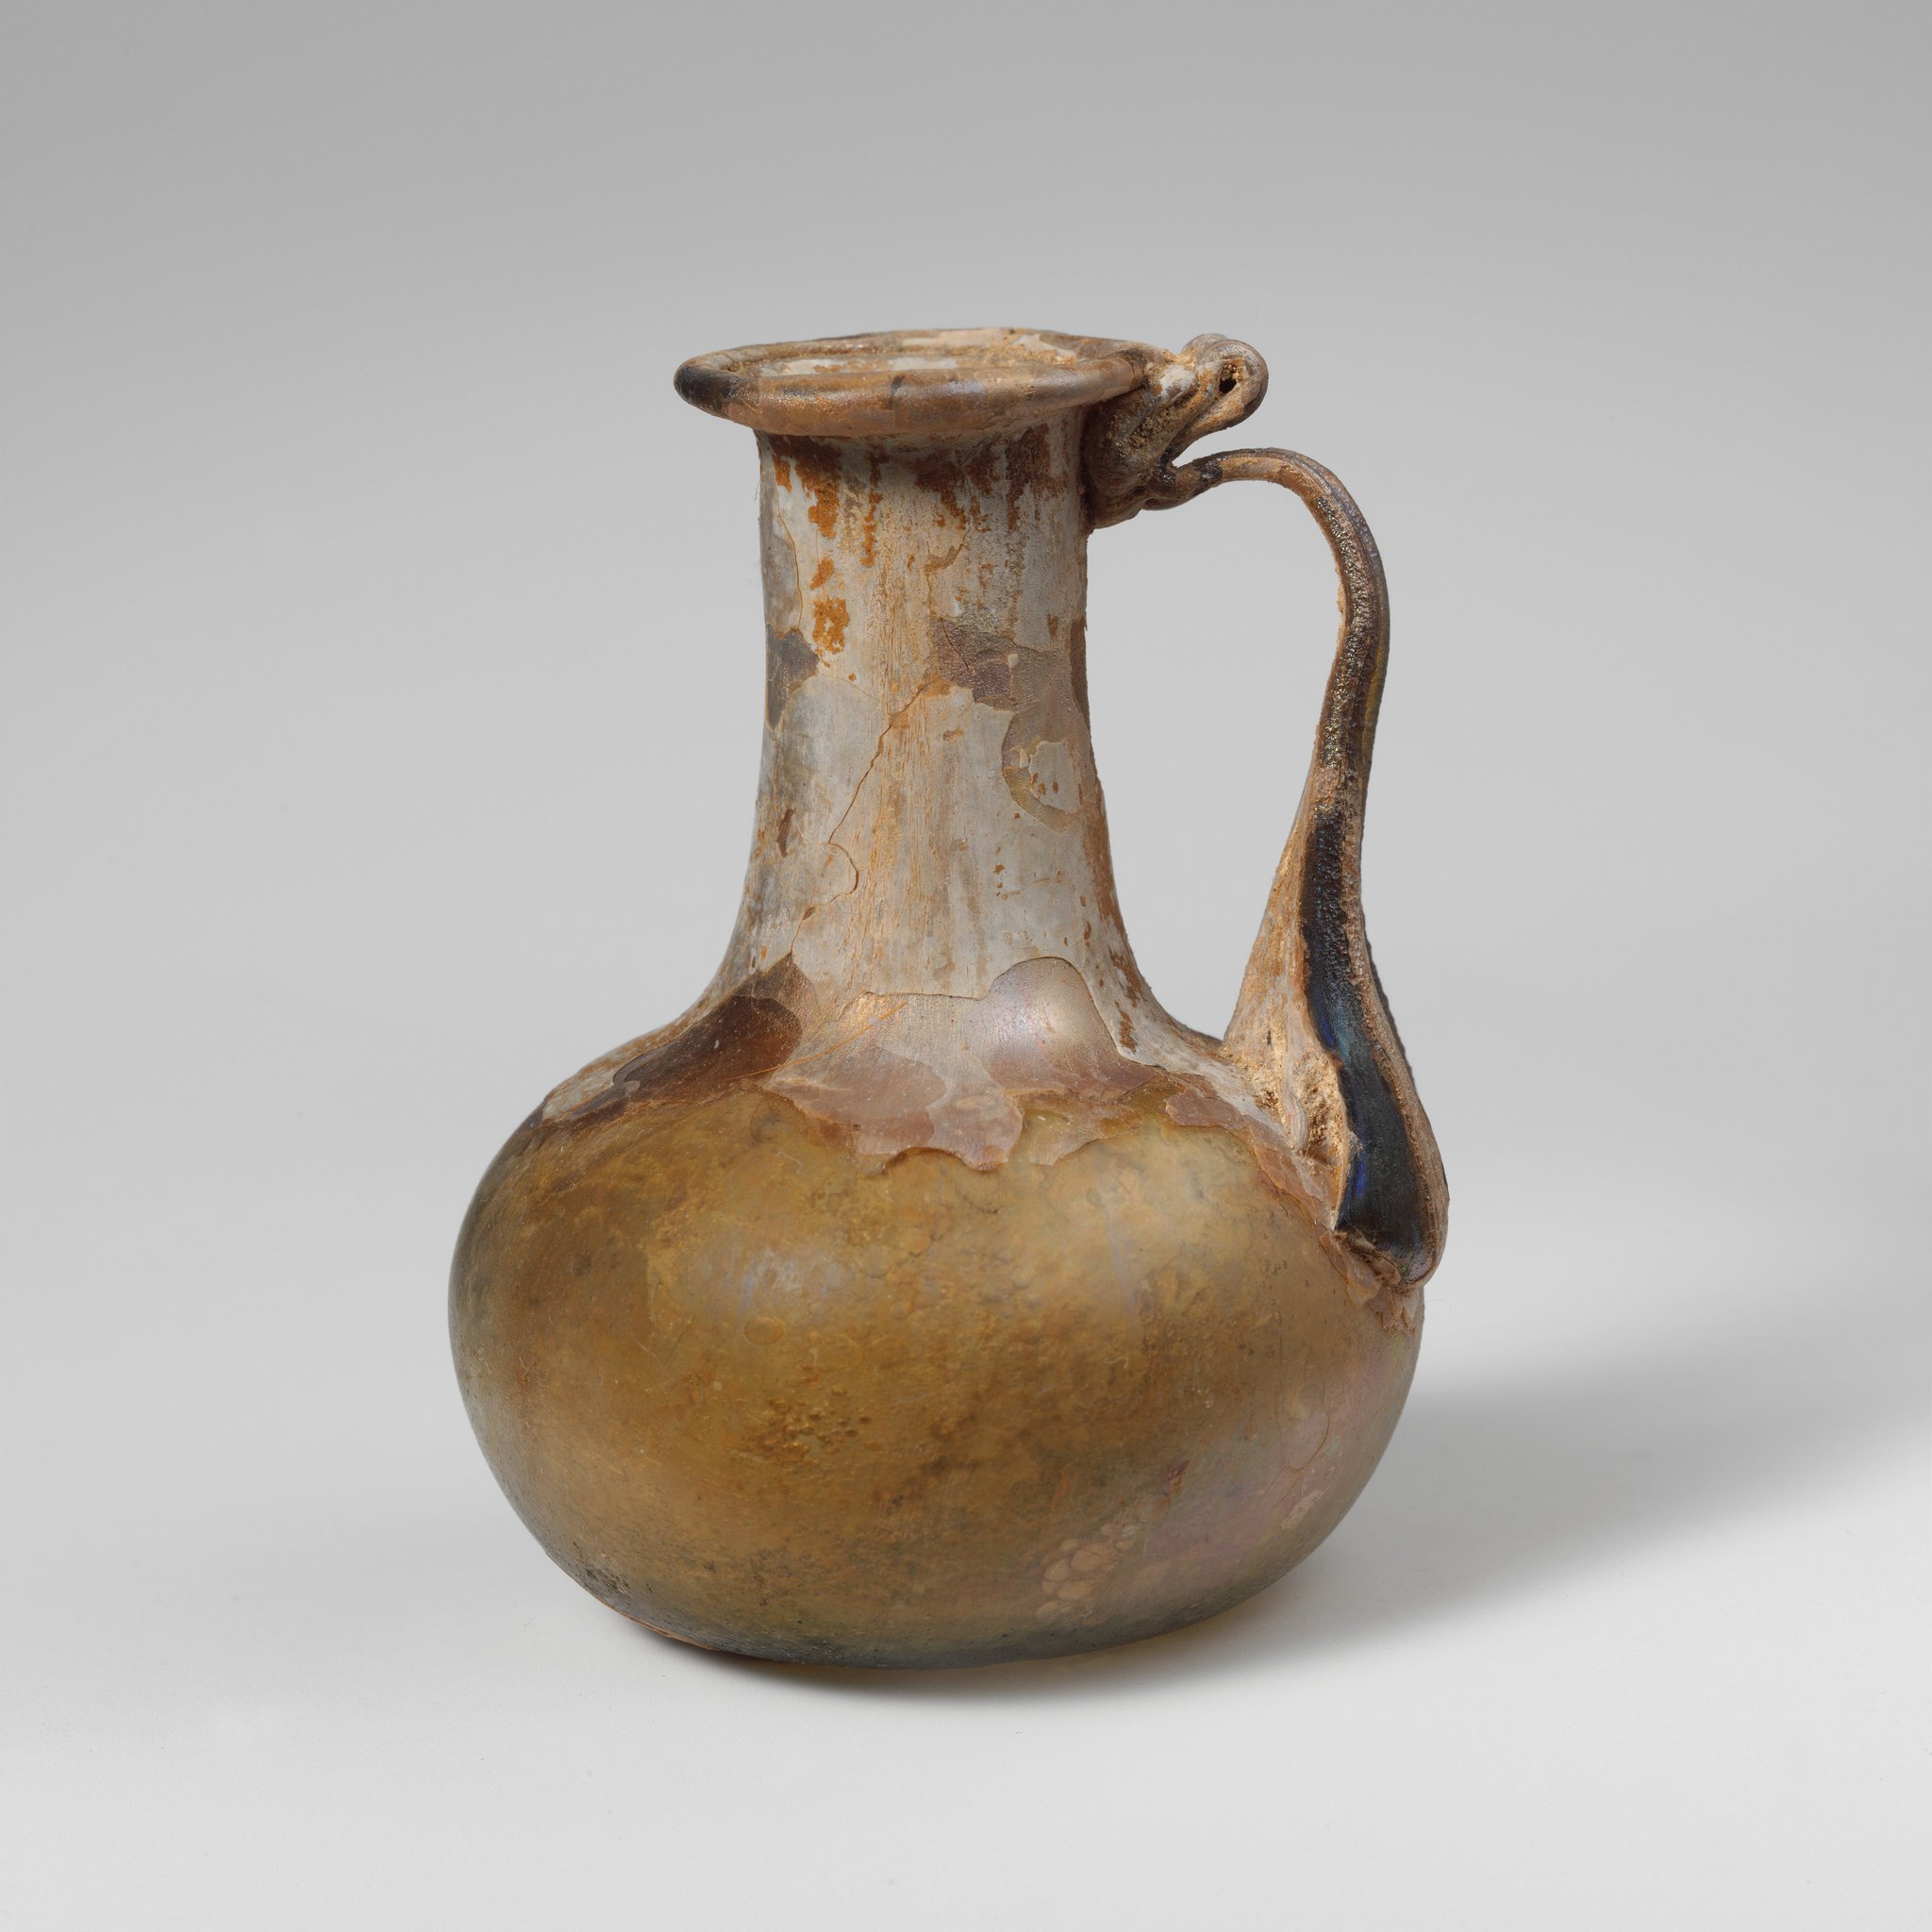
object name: jug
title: Glass jug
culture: roman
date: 101-300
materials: glass